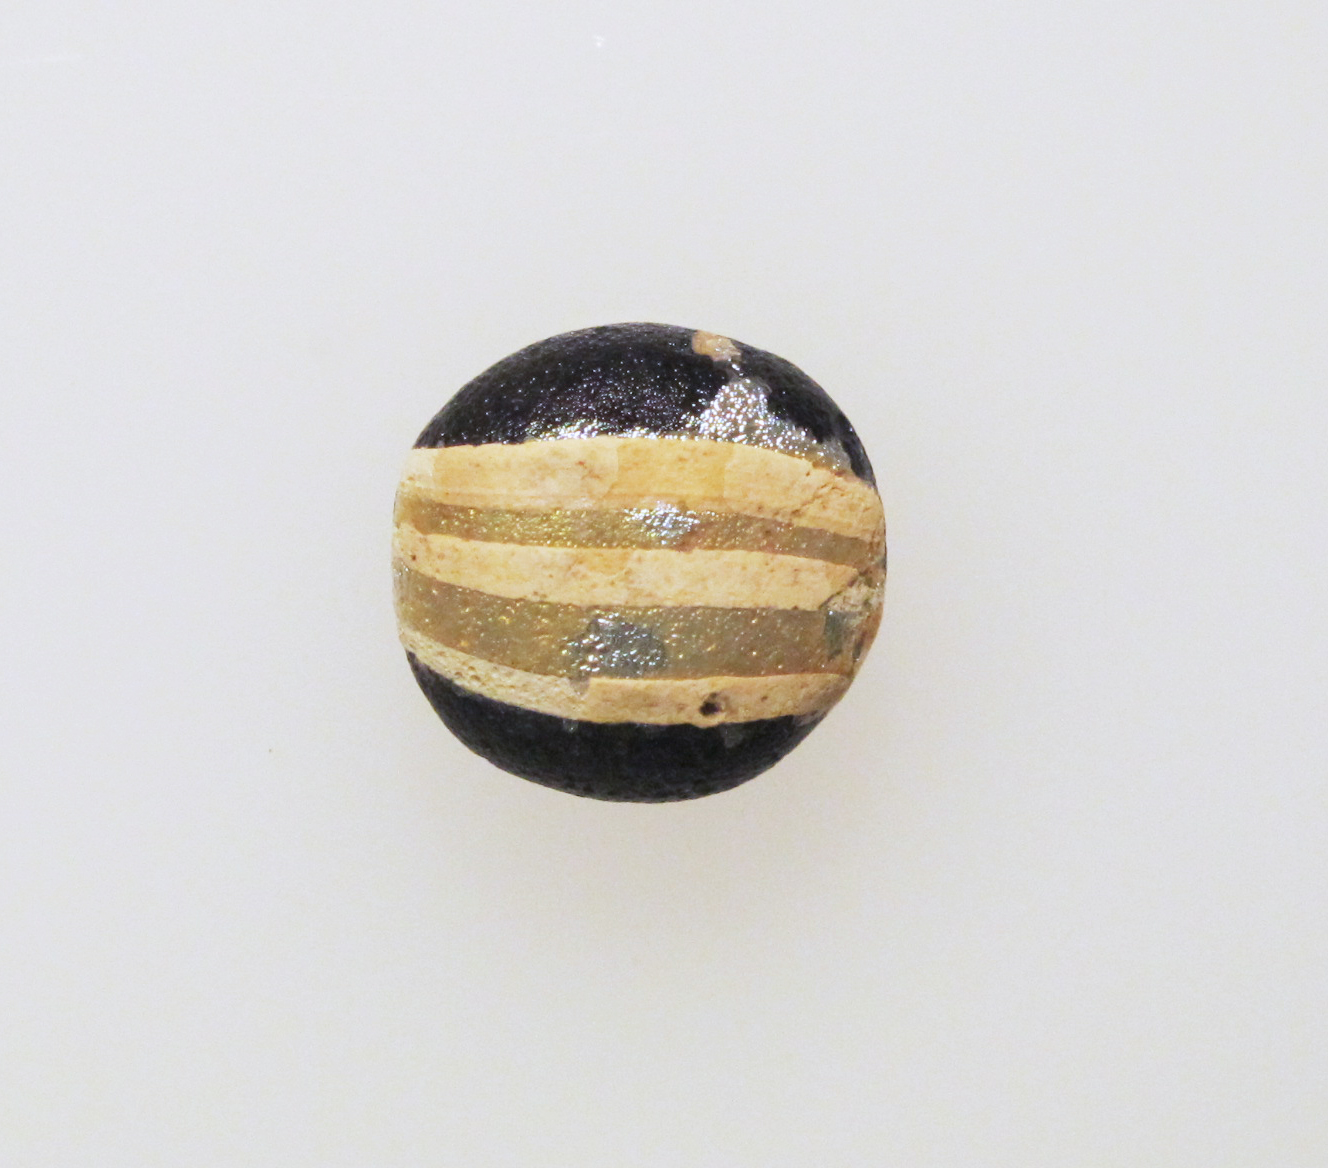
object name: pinhead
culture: roman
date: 670 BCE-330 CE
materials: glass